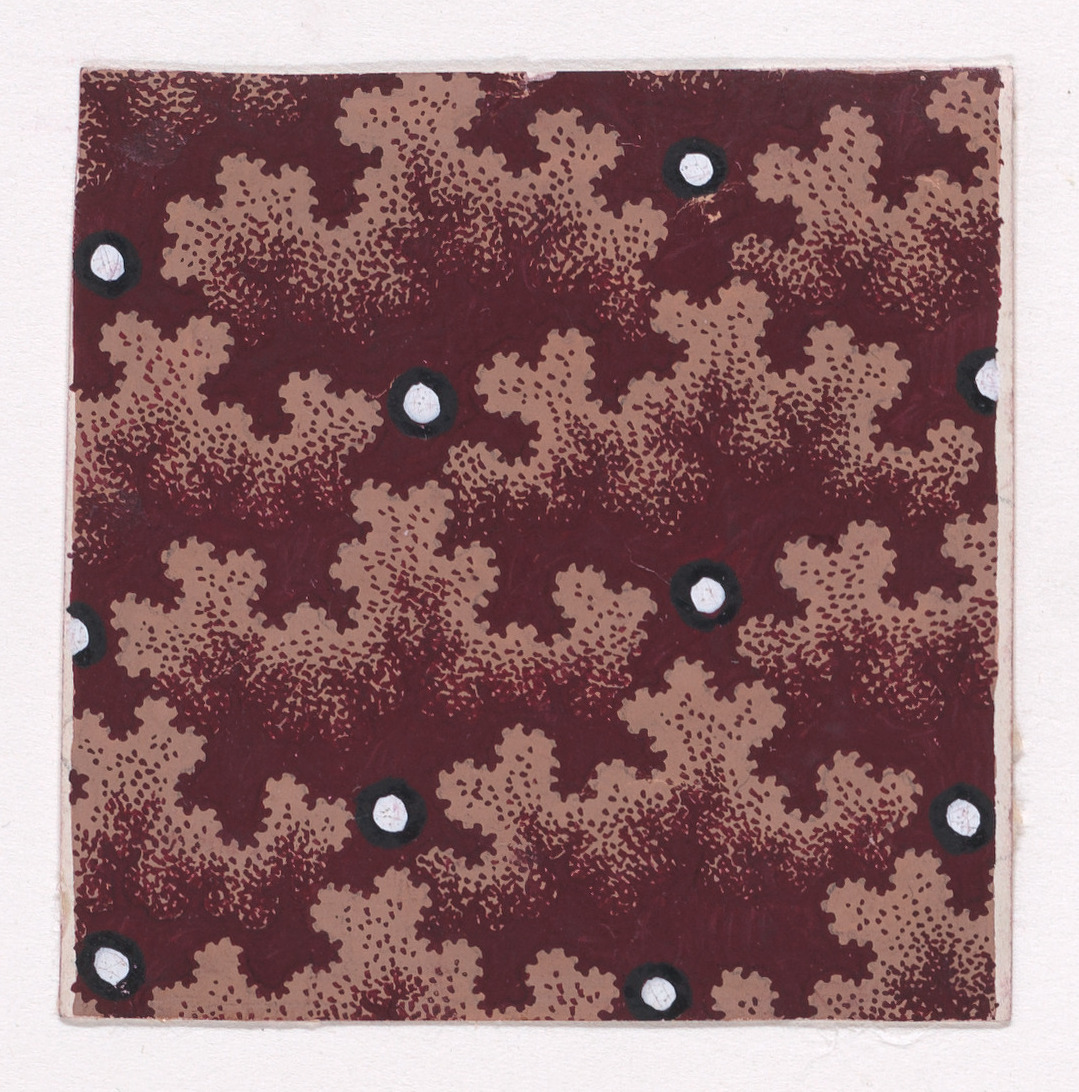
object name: drawing ornament architecture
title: Textile Design with Alternating Vertical and Horizontal Rows of Pearls Over a Background of Alternating Horizontal Garlands of Abstract Bushes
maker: anonymous, alsatian, 19th century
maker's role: artist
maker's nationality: alsatian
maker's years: 1800-1900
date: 1840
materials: gouache